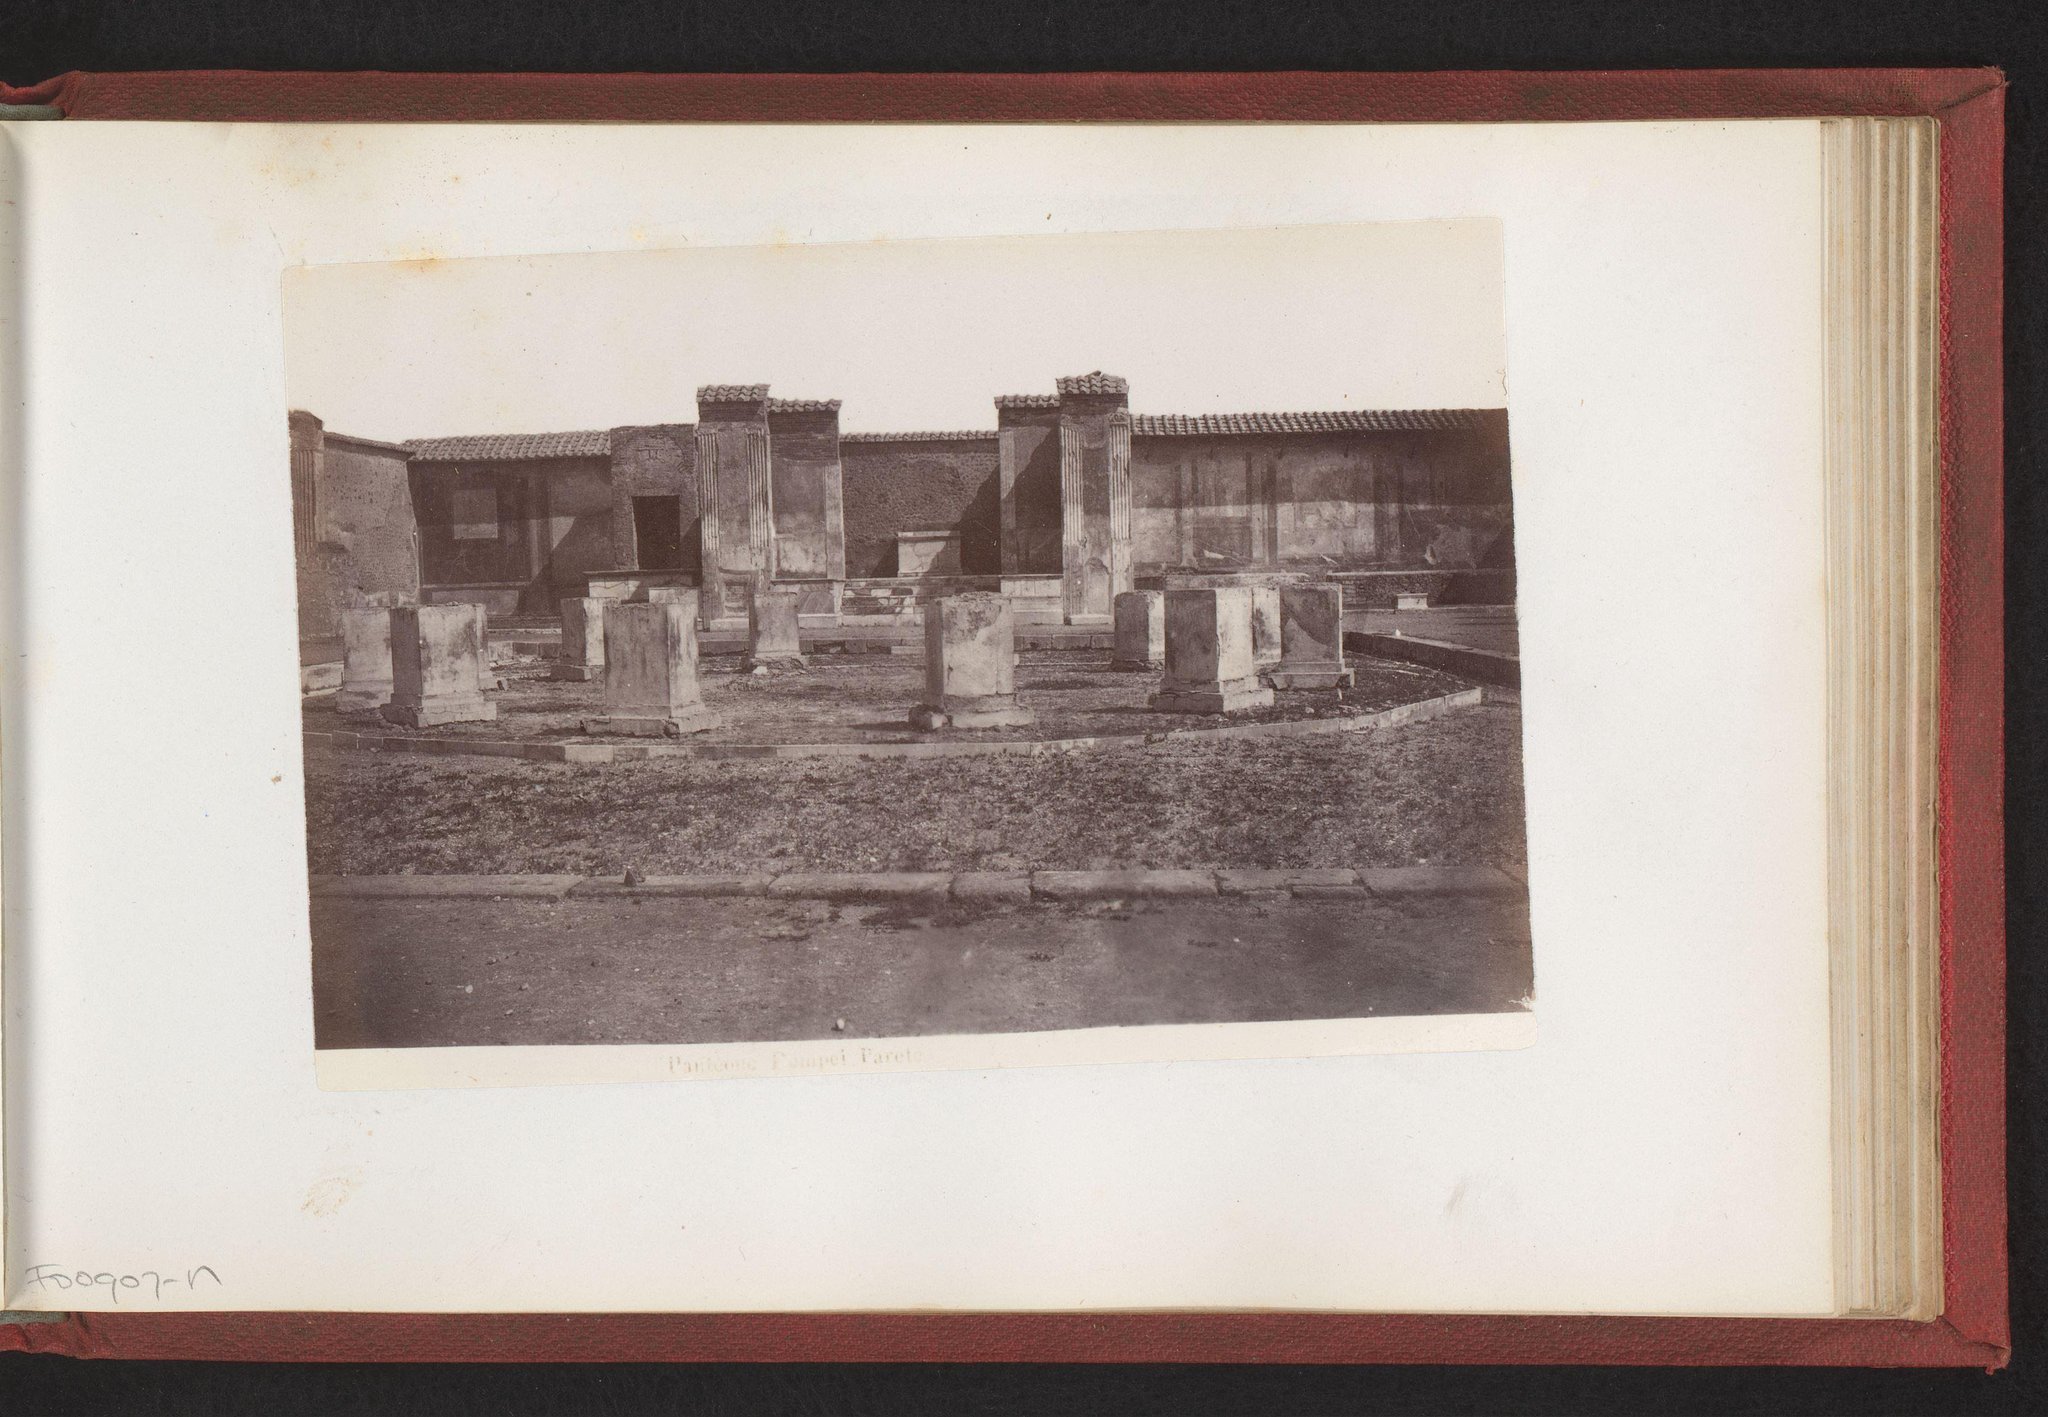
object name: photograph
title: Panteone Pompei Parete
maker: Anonymous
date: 1860-1900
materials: photographic support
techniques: albumen print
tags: ruin of a building ~ architecture